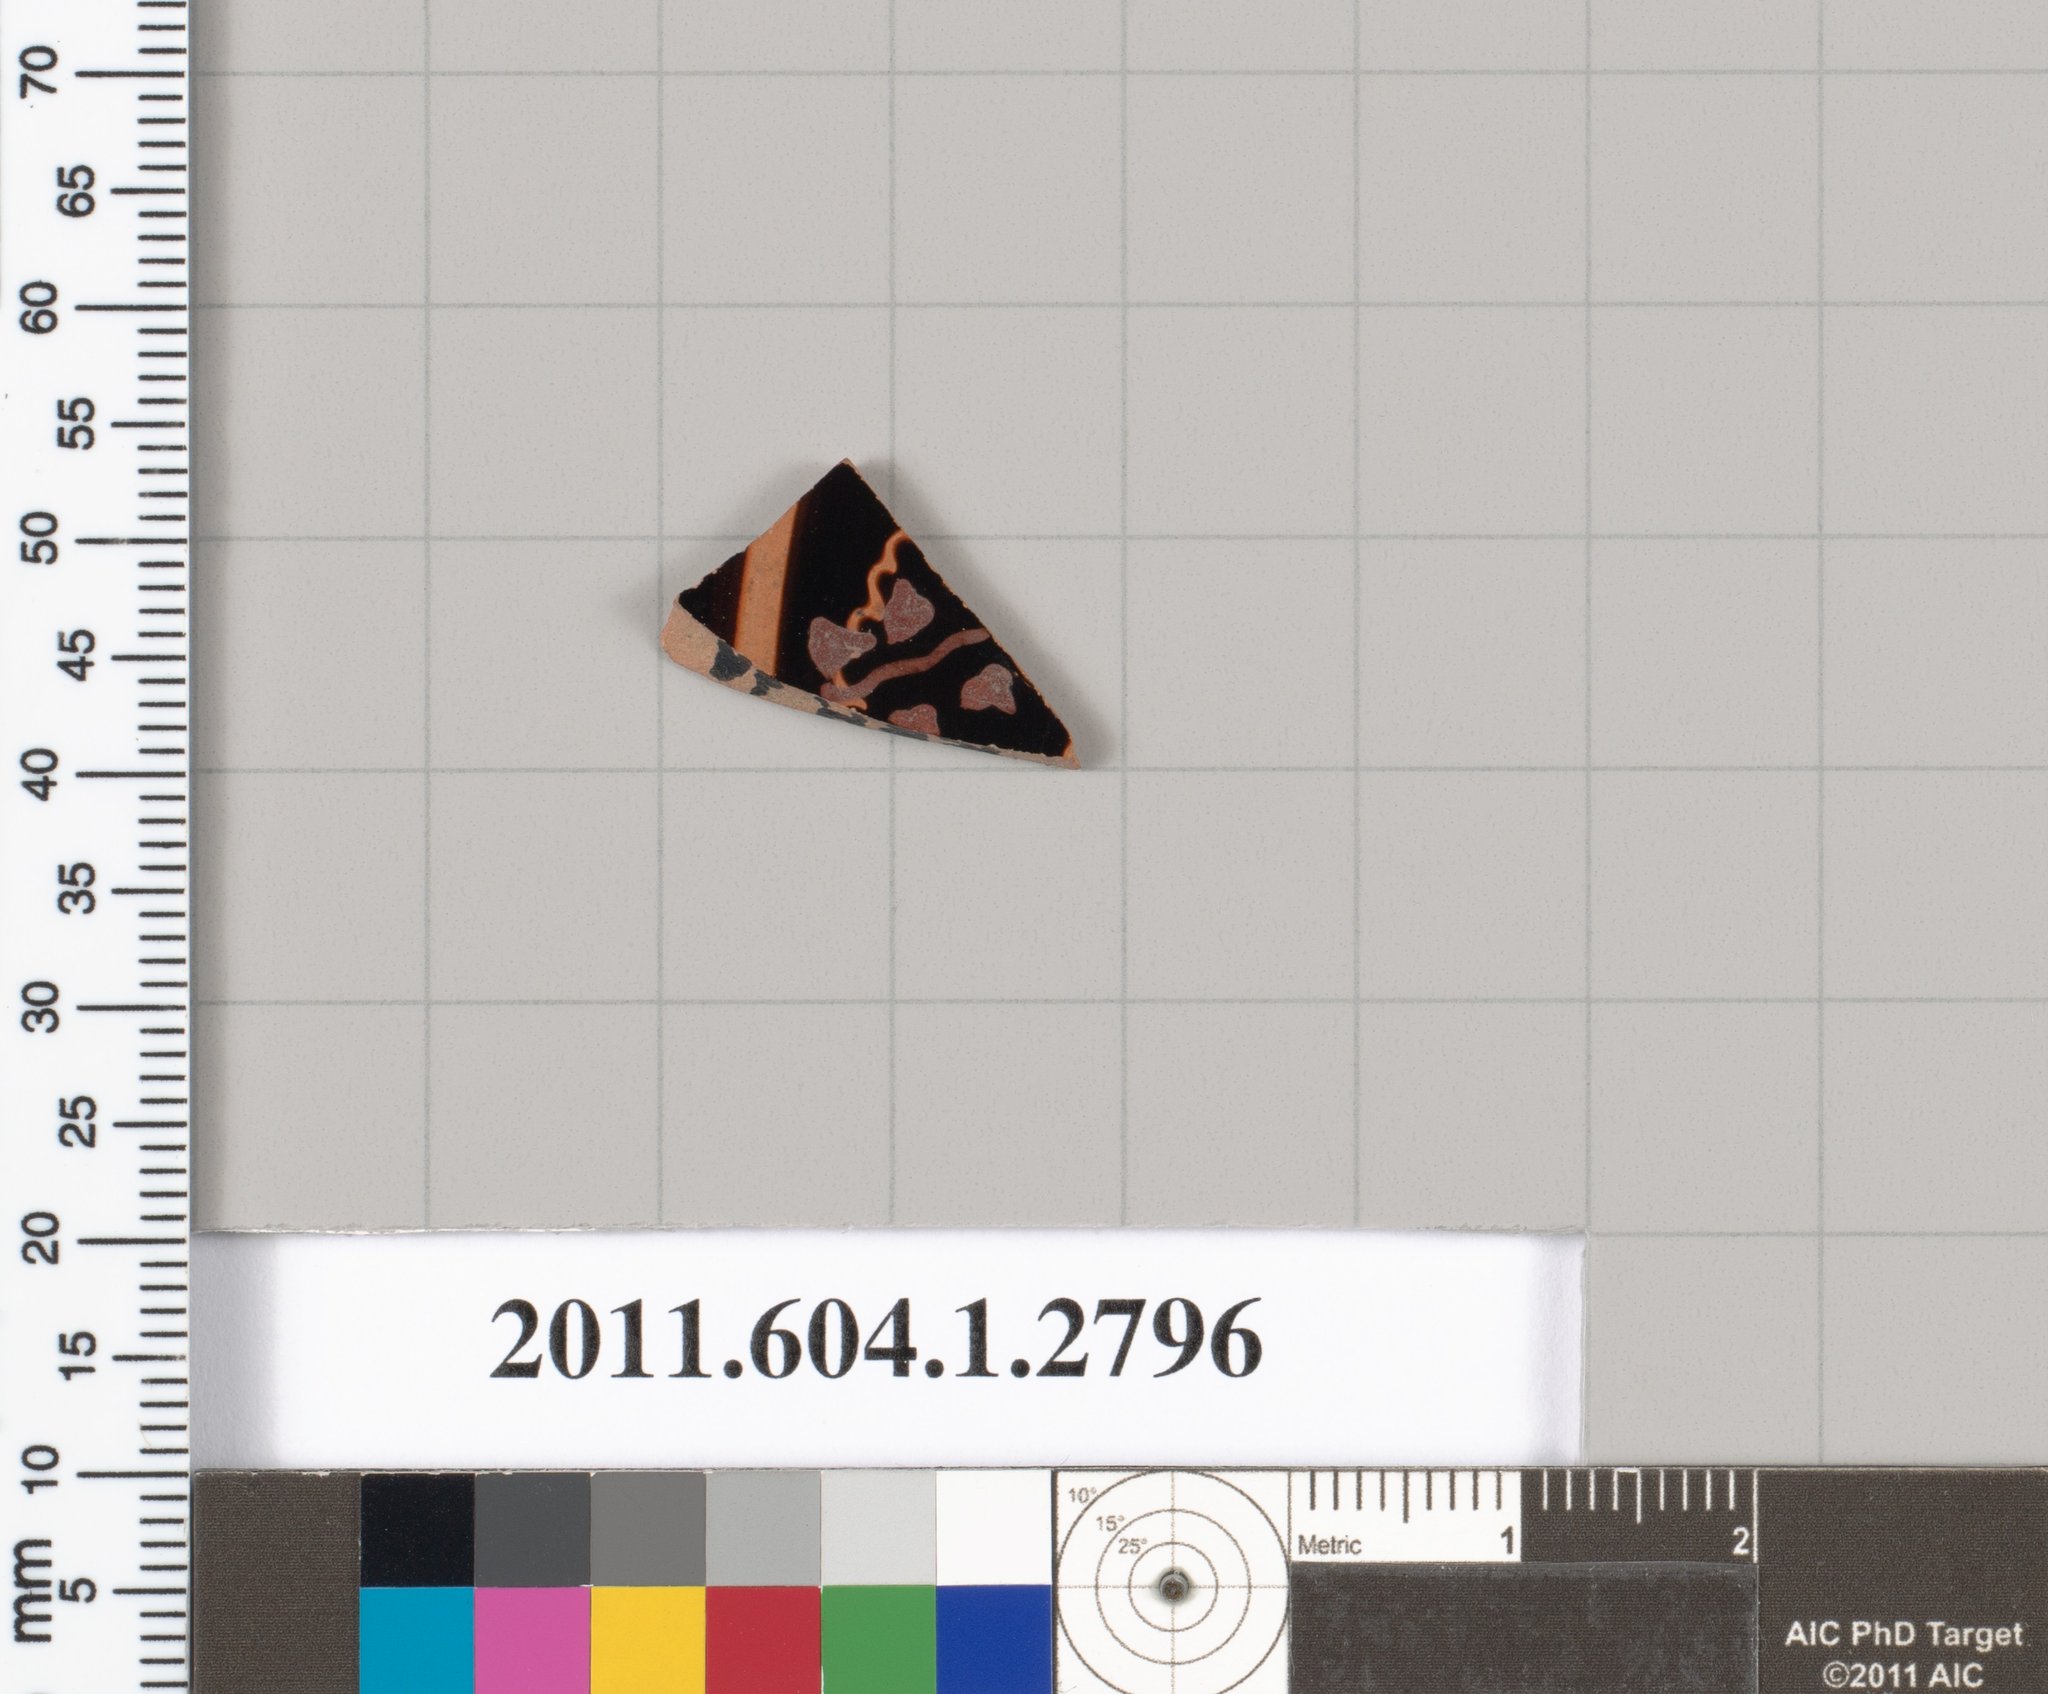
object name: kylix fragment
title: Terracotta fragment of a kylix (drinking cup)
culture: greek, attic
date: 520-500 BCE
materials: terracotta